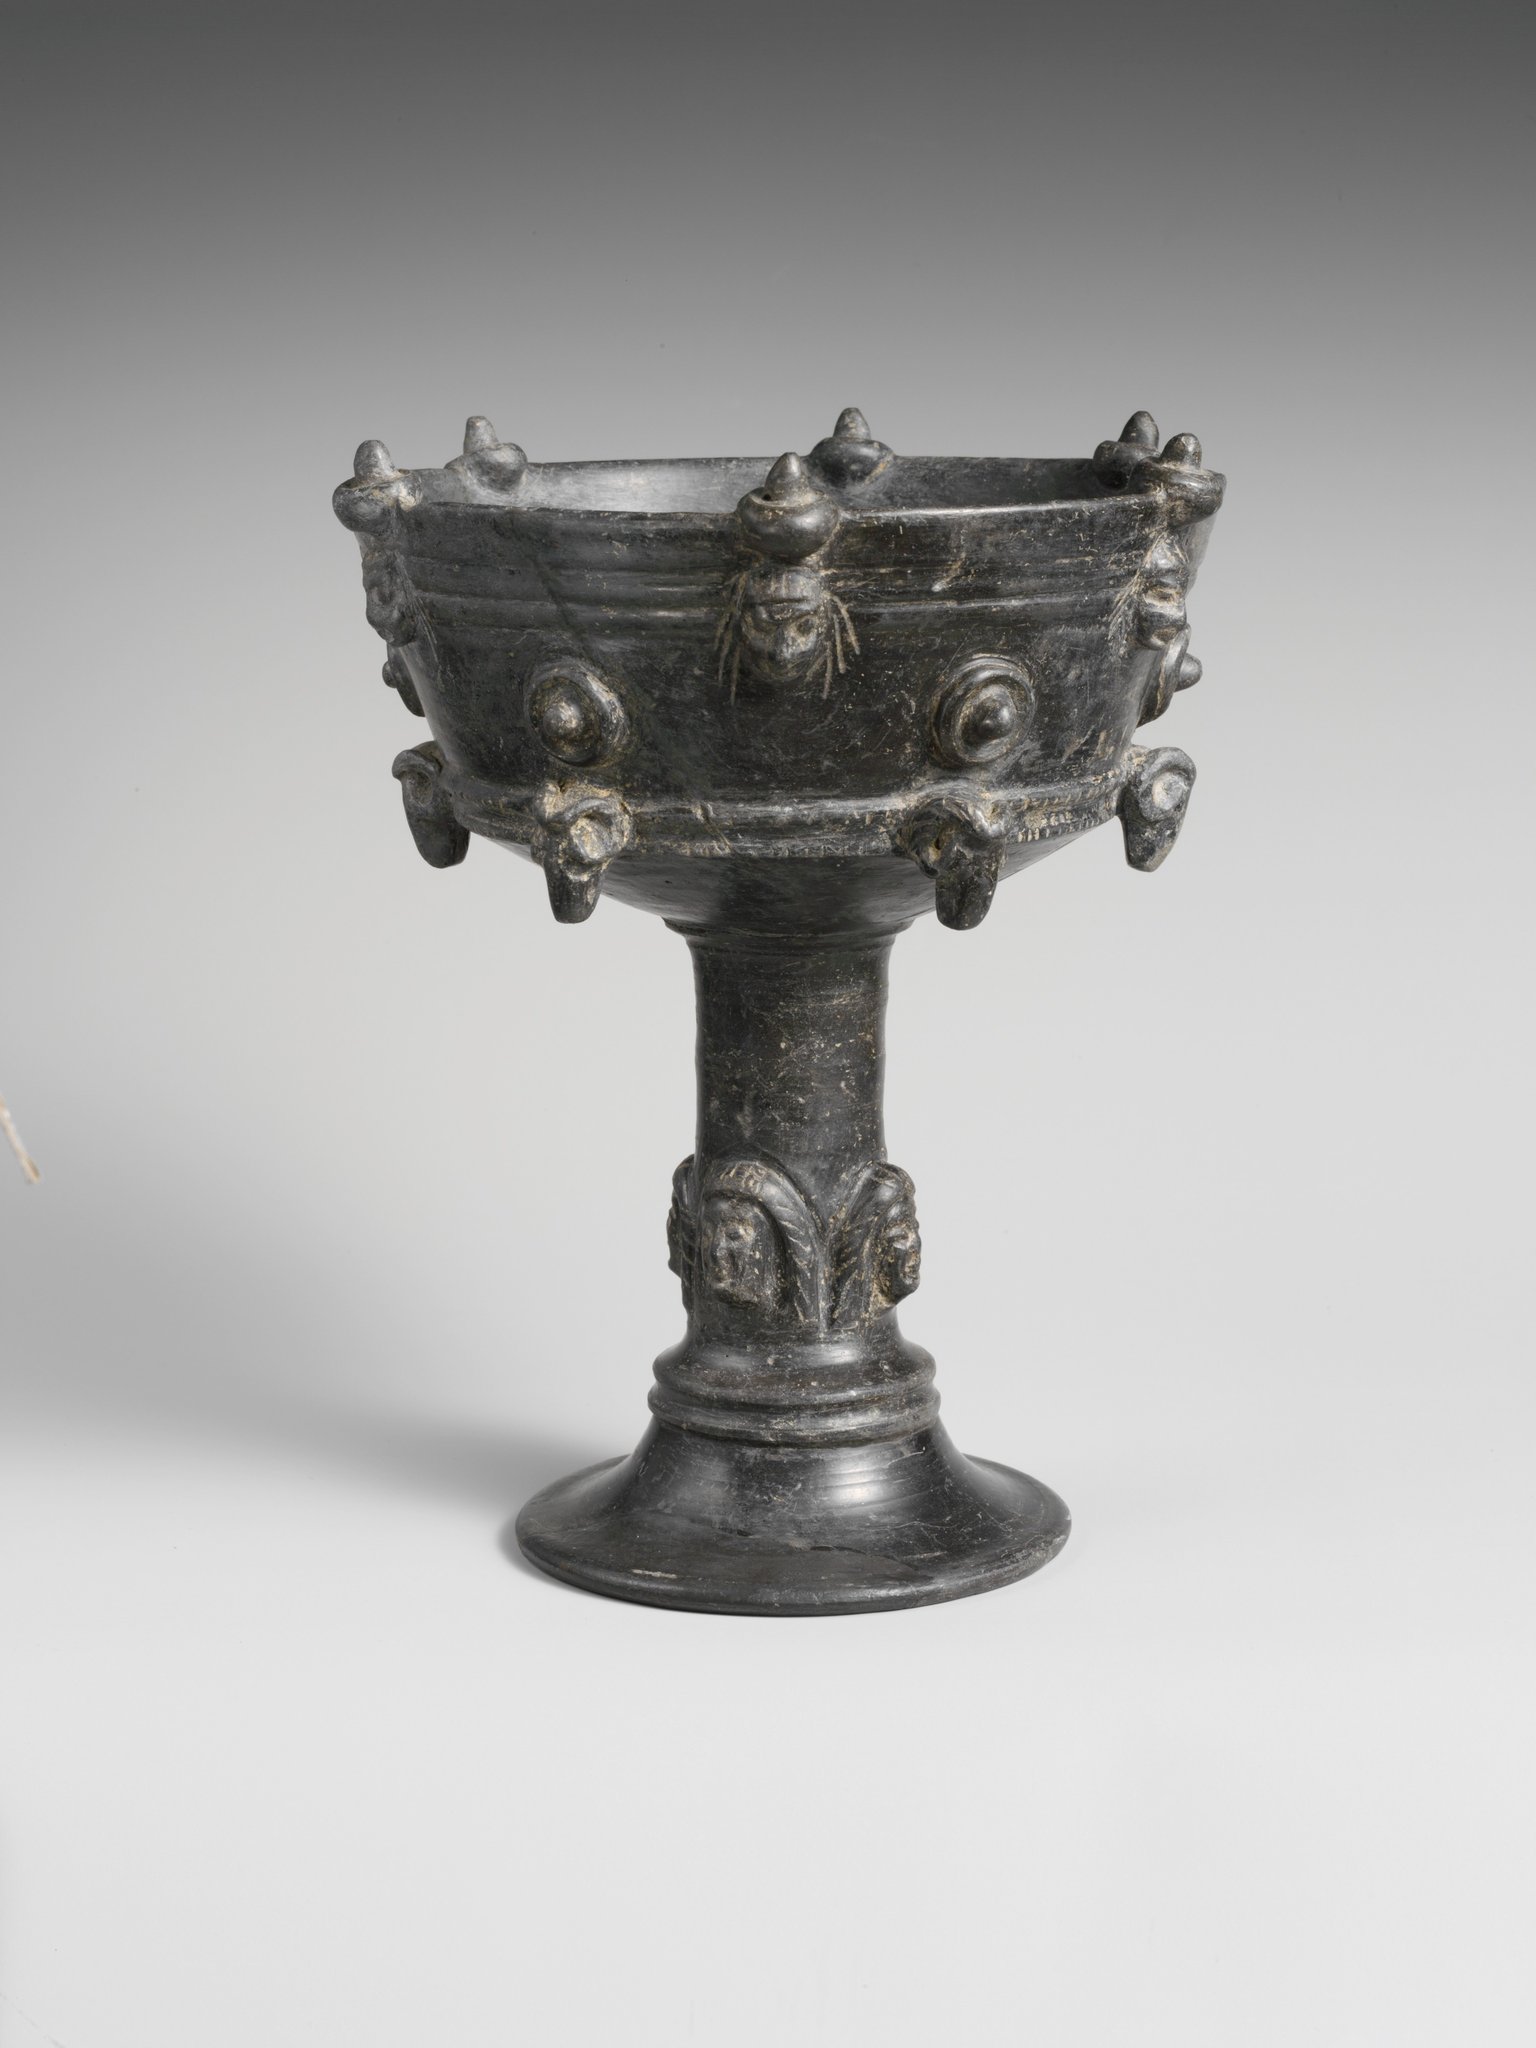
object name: cup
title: Terracotta chalice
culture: etruscan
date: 575-550 BCE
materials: terracotta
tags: heads,rams